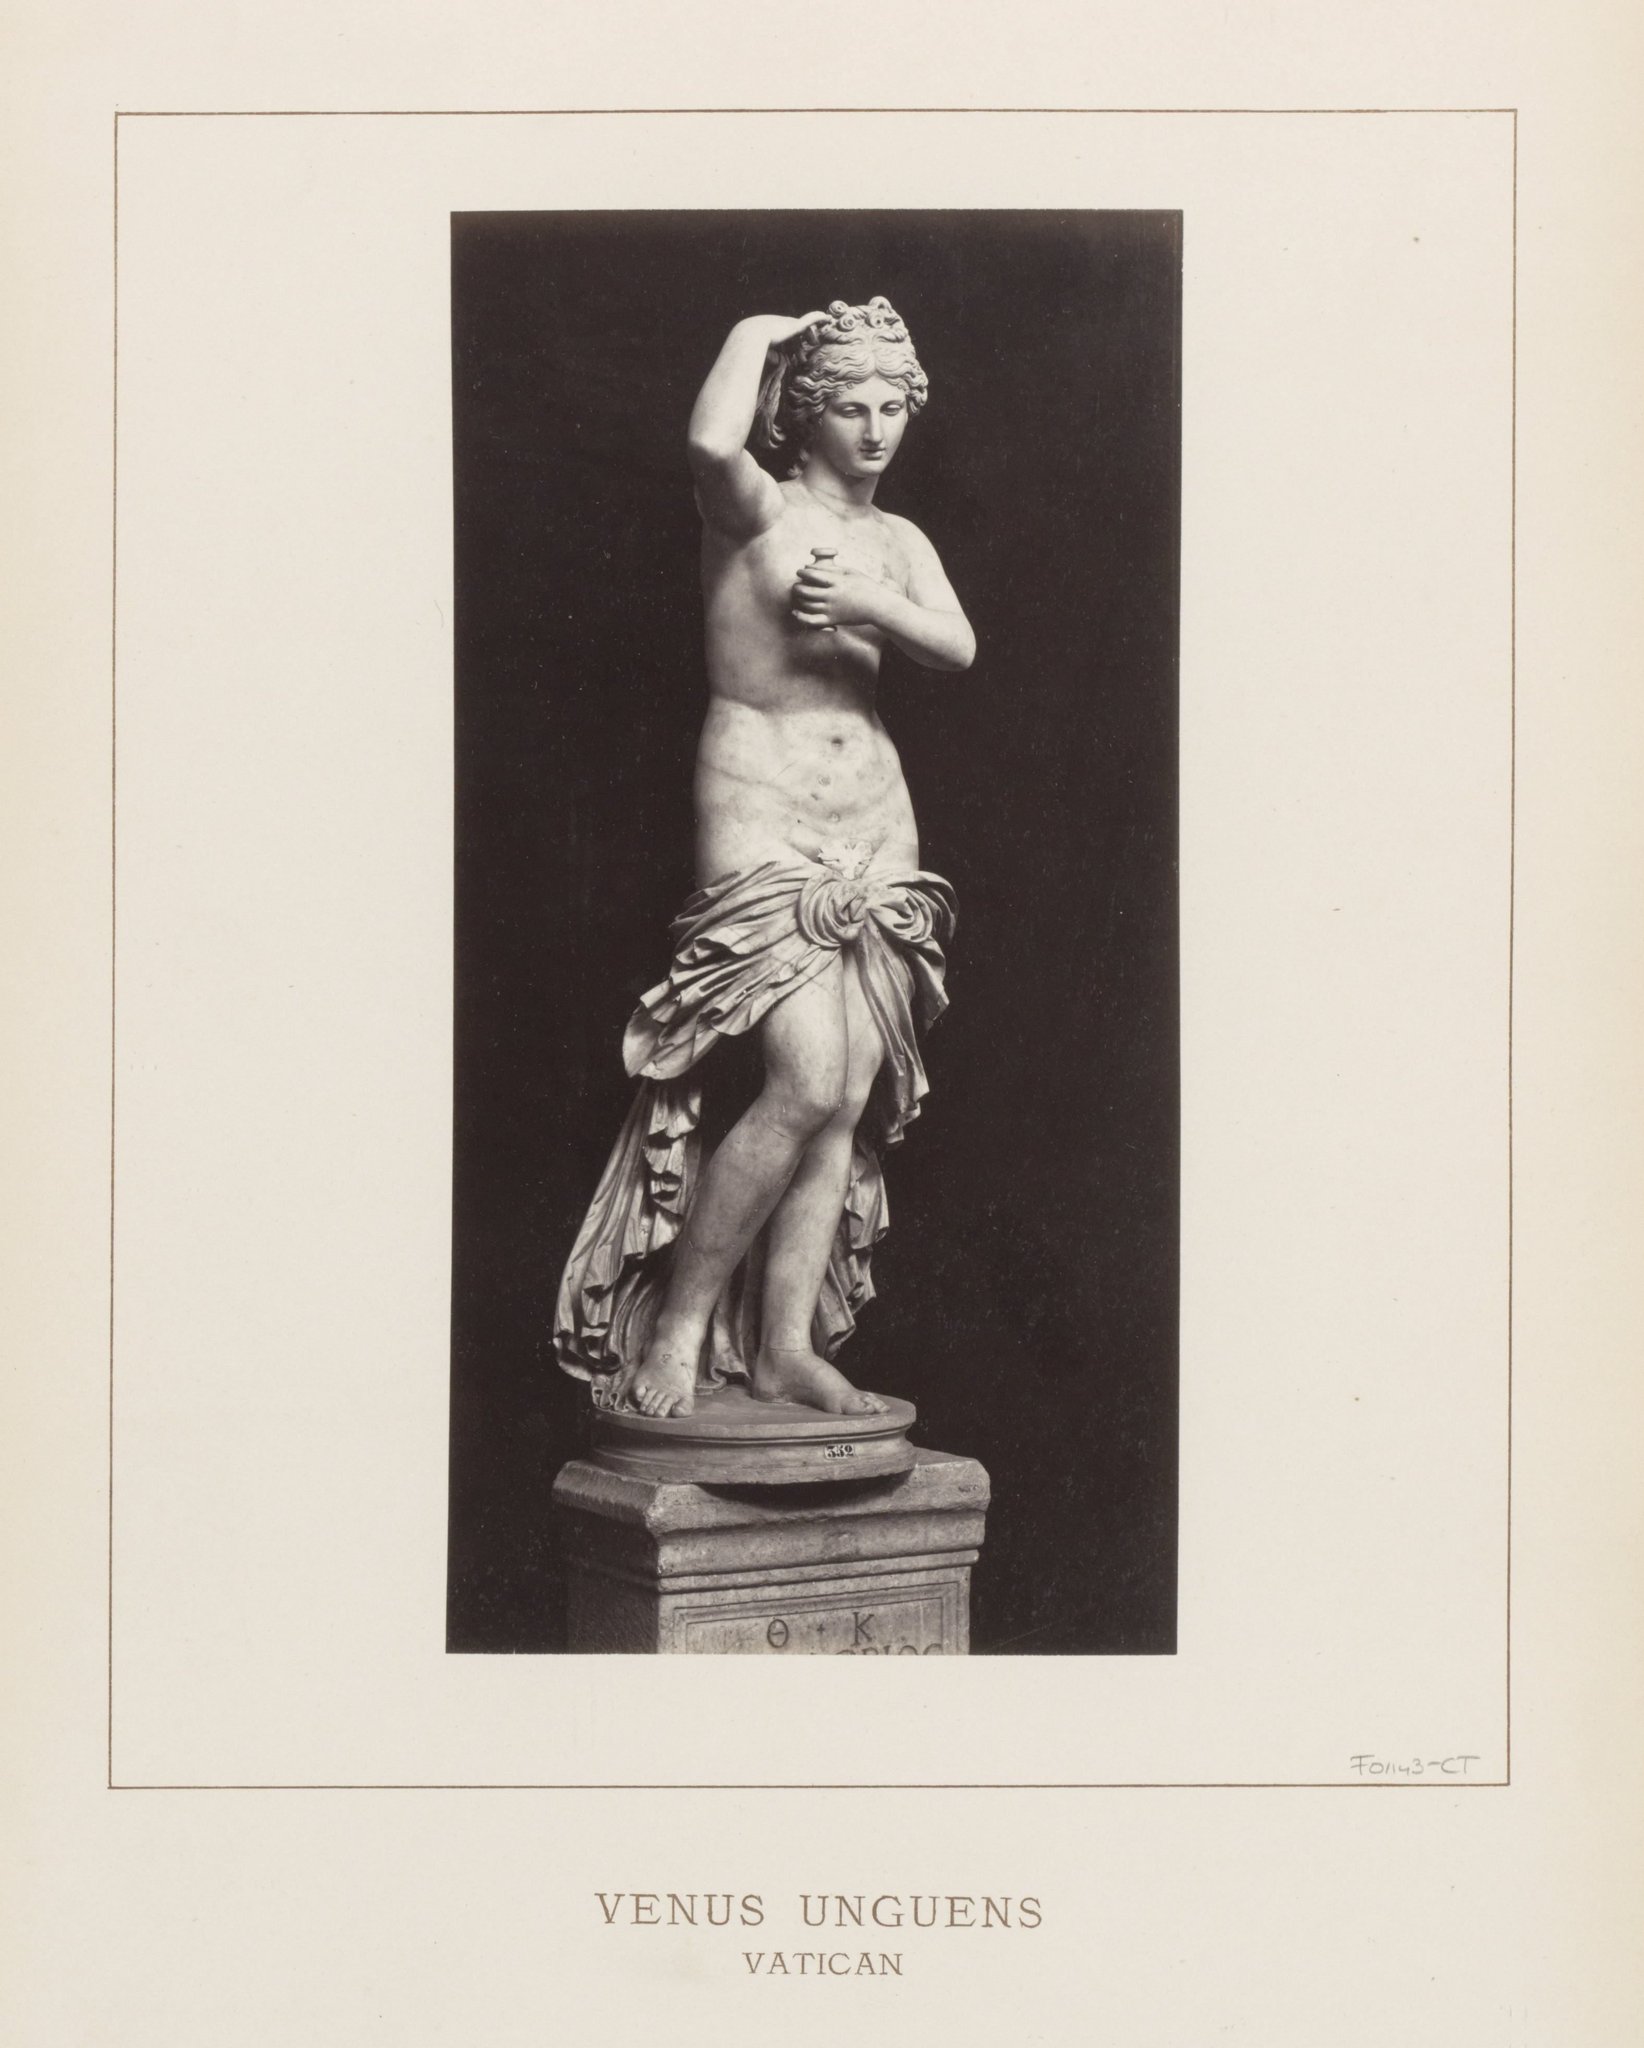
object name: photograph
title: Venus unguens, Vatican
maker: Anonymous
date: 1860-1900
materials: photographic support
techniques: albumen print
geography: vatican city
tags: piece of sculpture, reproduction of a piece of sculpture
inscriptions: number: ‘352’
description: Onderdeel van Fotoalbum met opnames van bezienswaardigheden en kunstwerken in Rome.